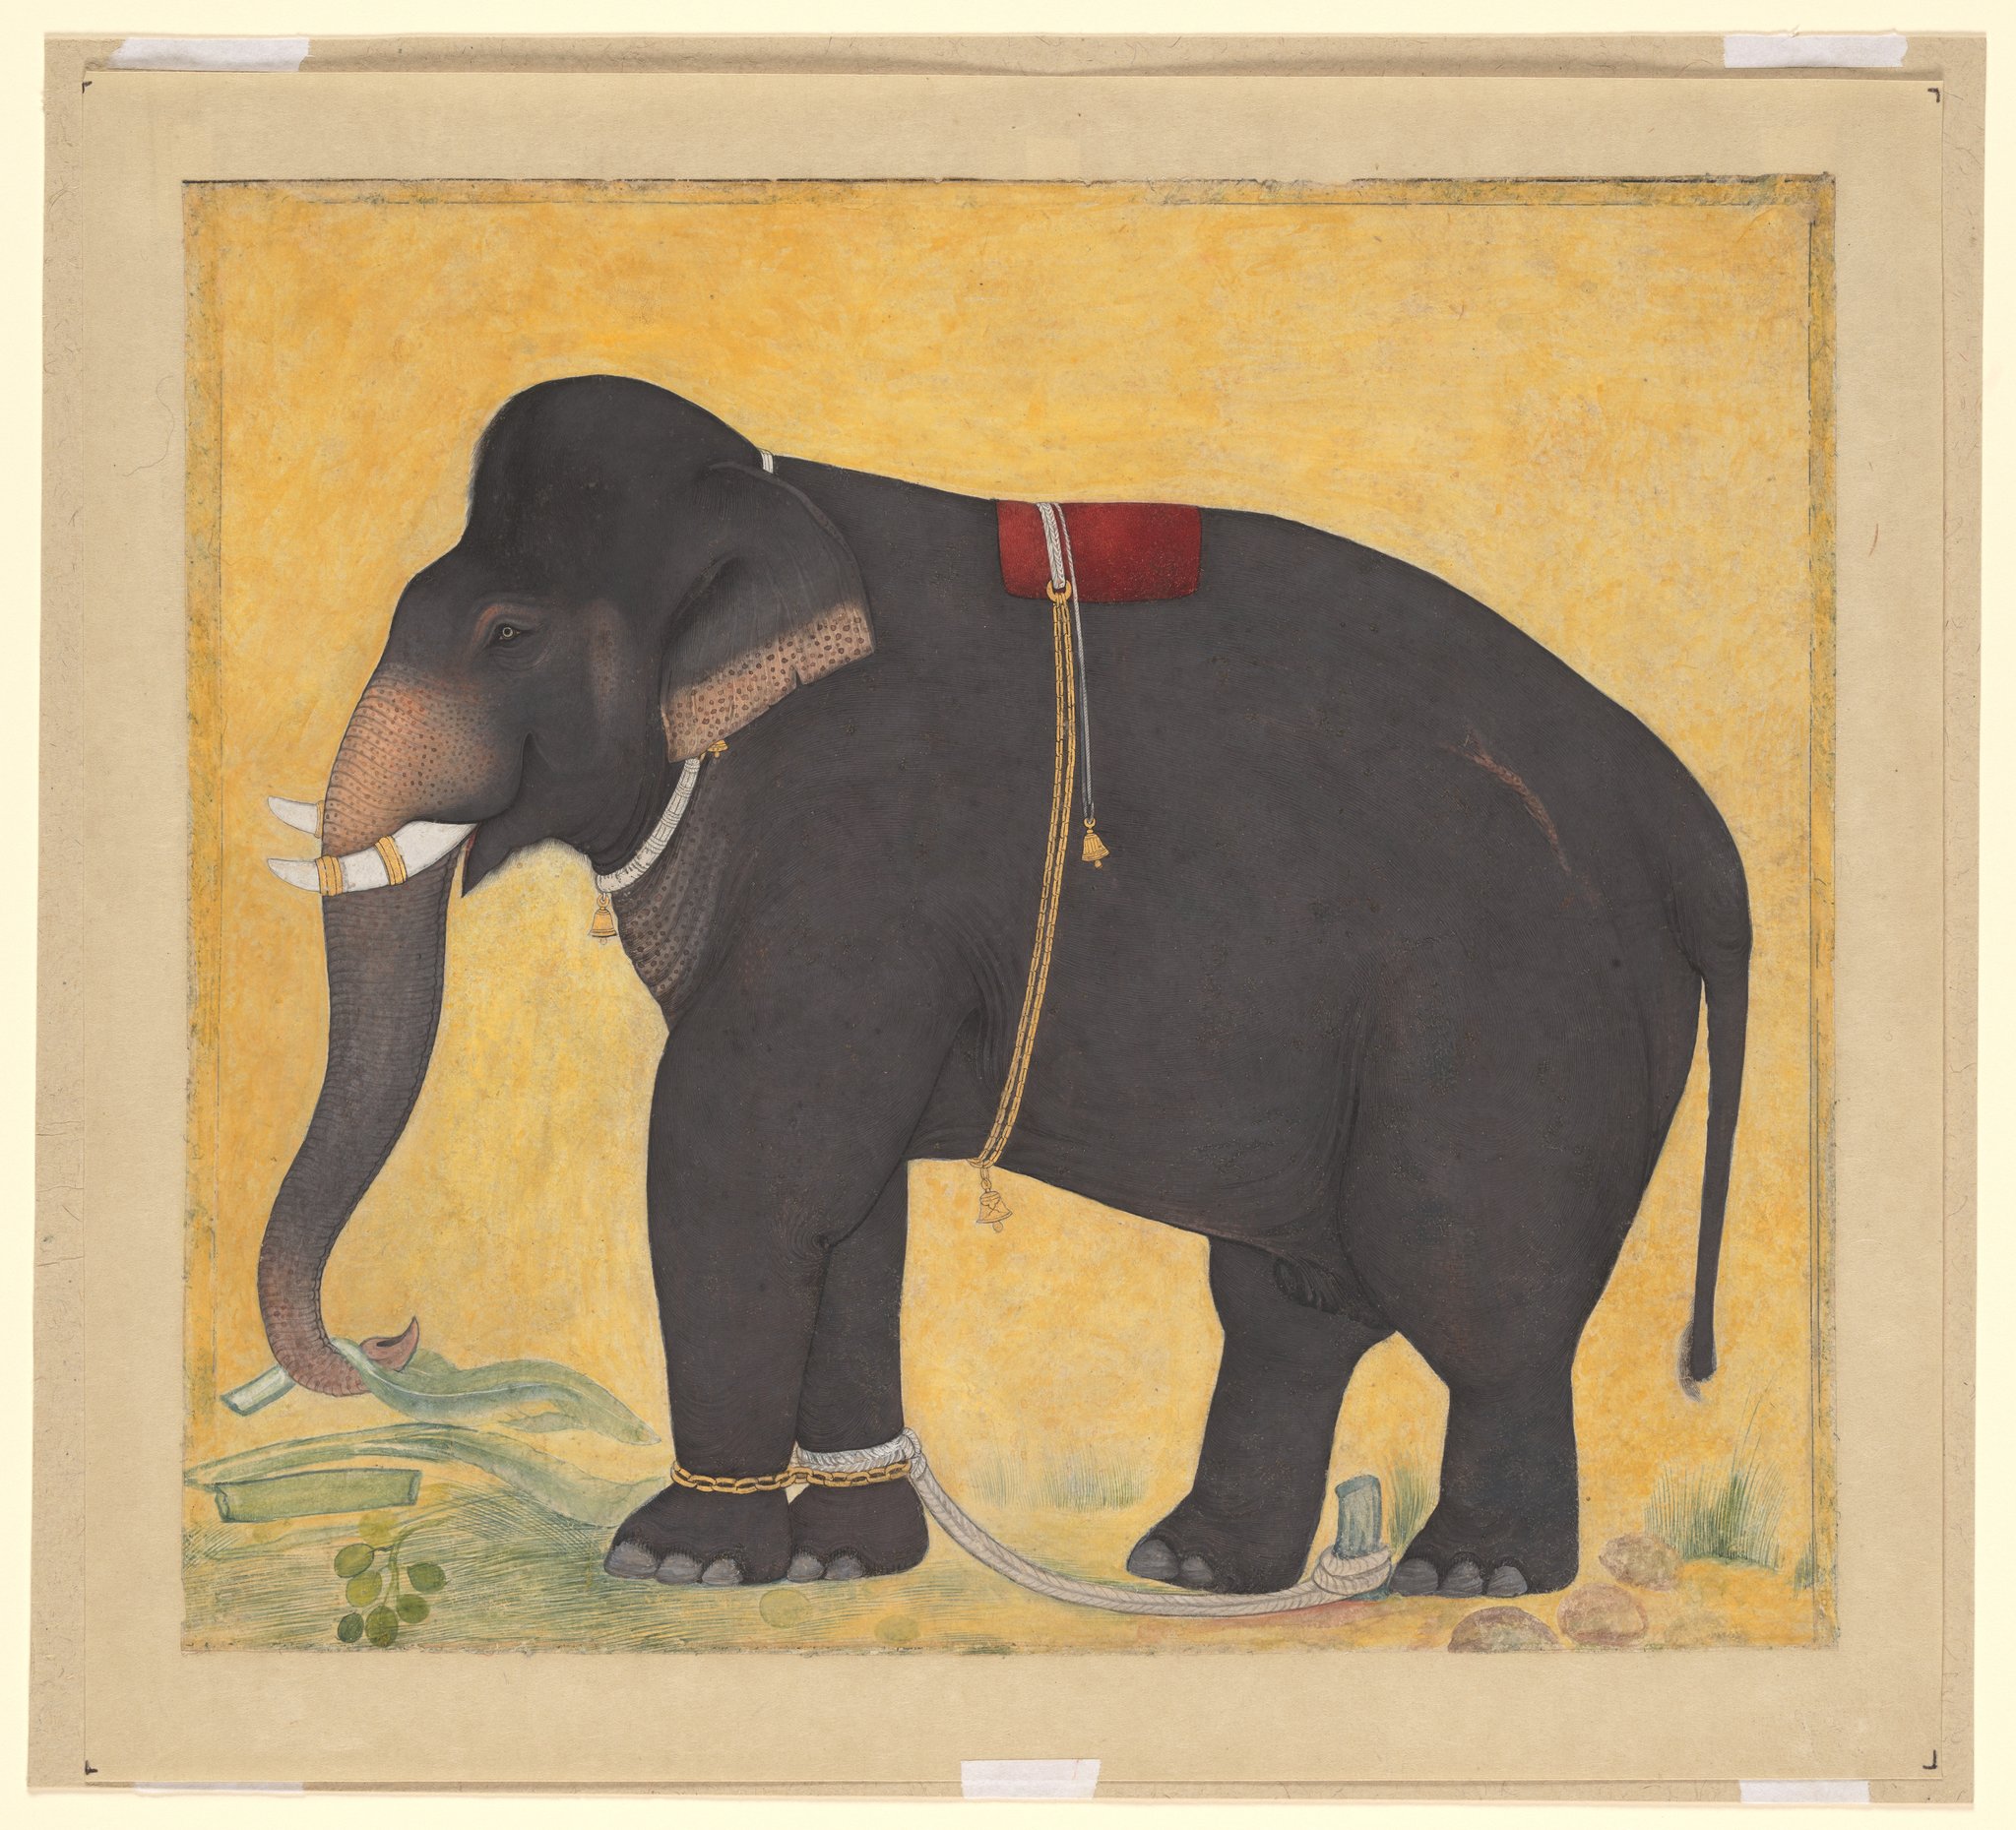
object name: illustrated single work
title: Young Elephant Eating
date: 1650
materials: gold, paper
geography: india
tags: elephants